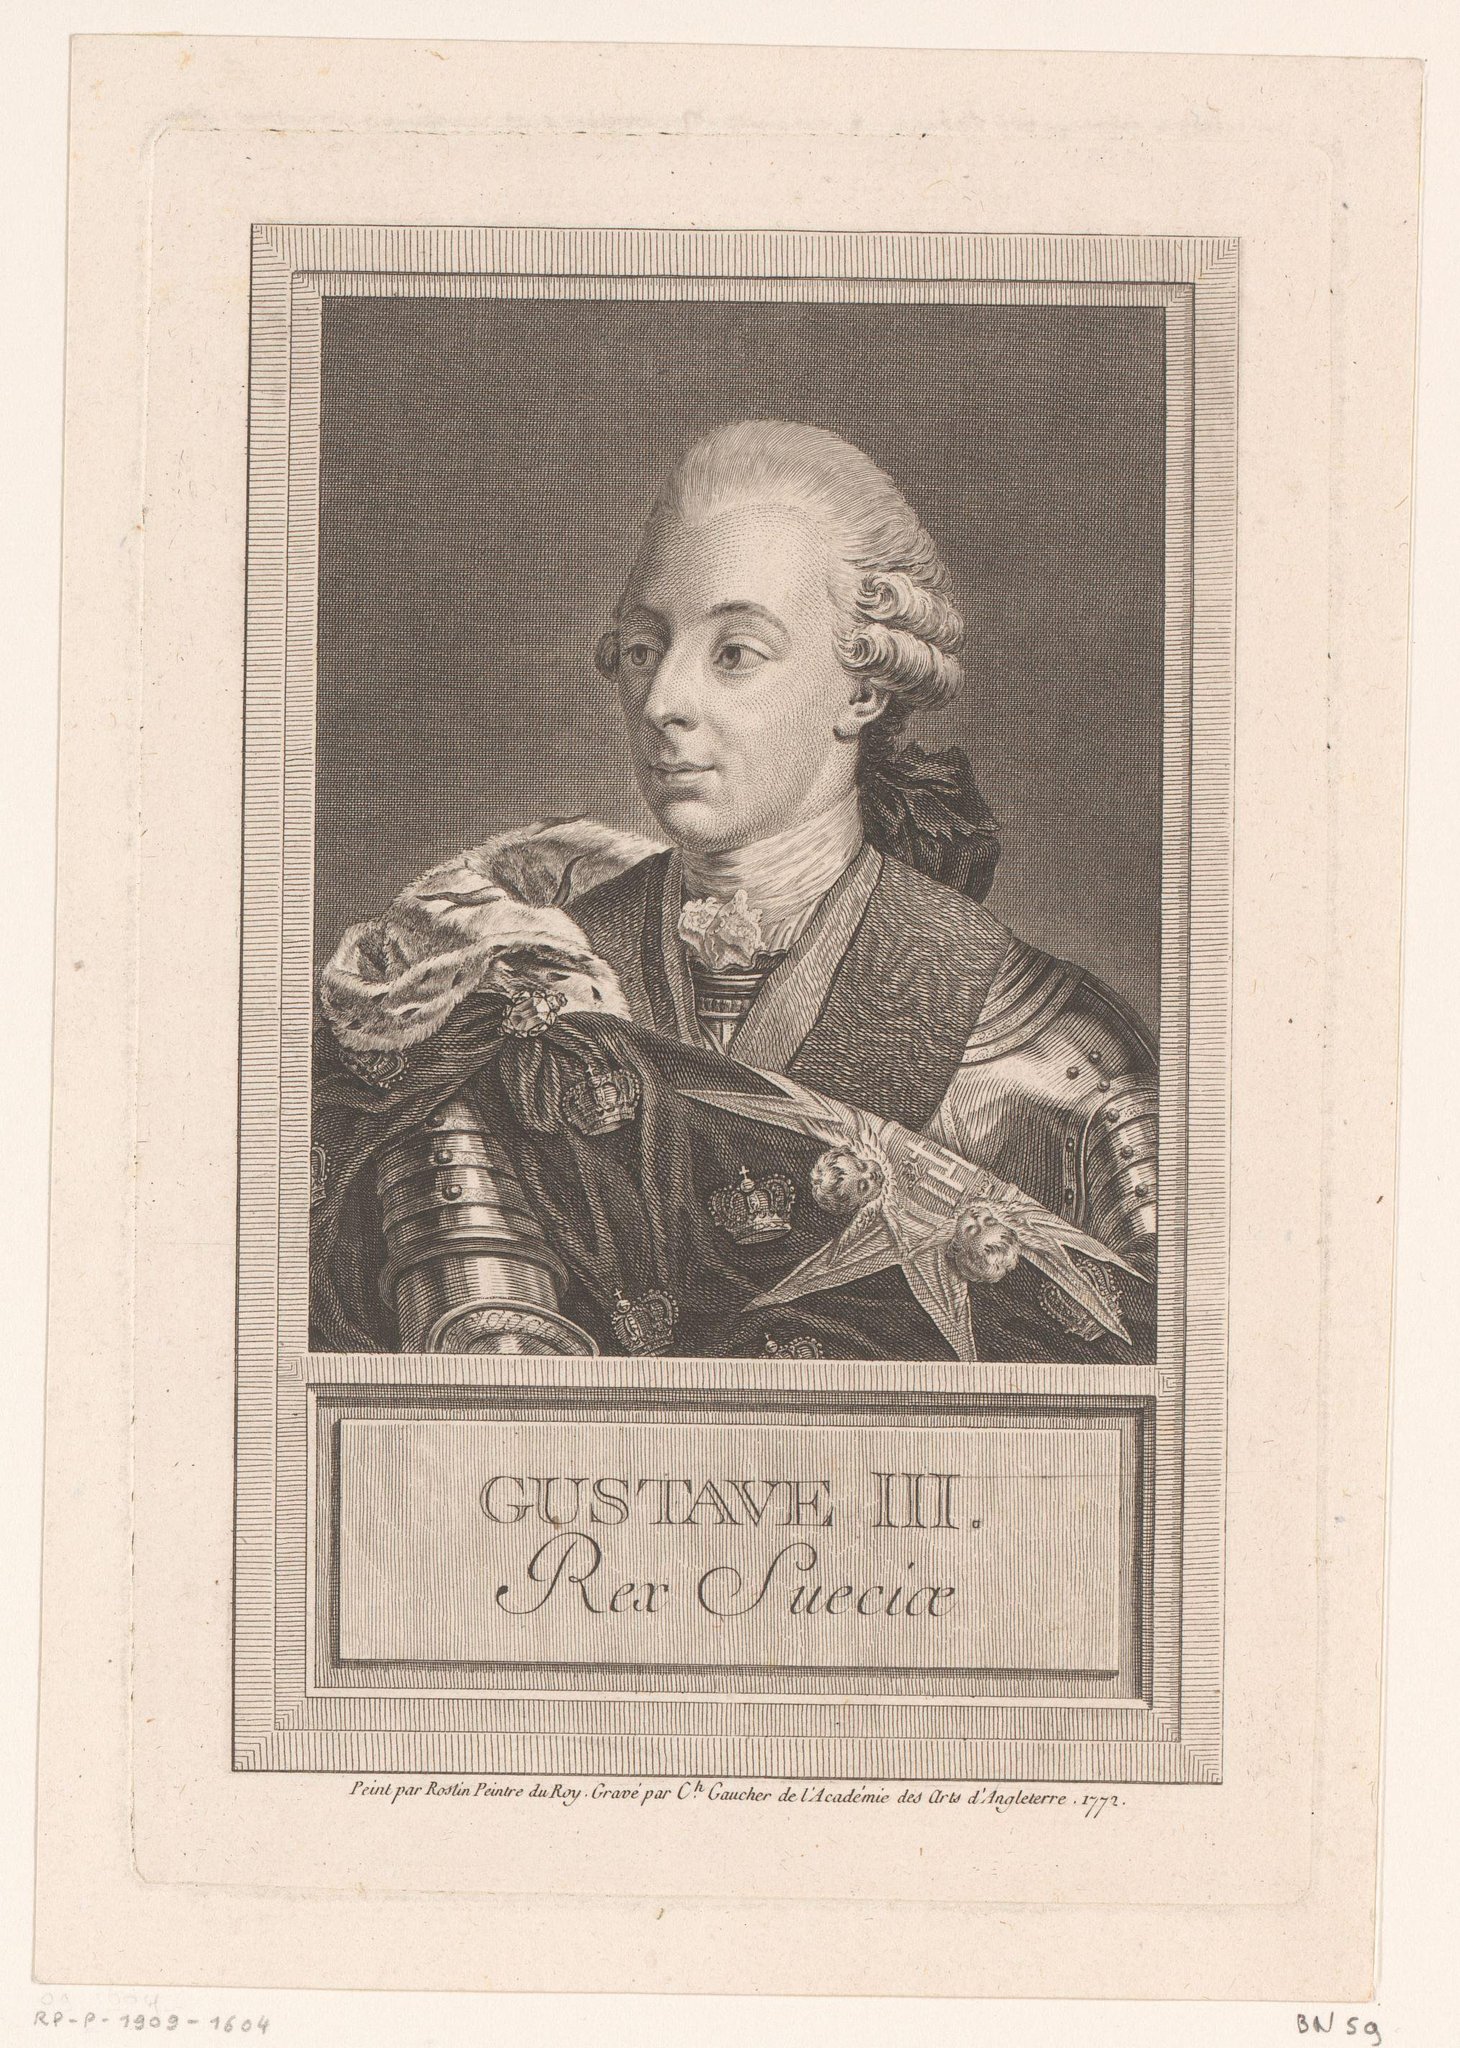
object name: print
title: Gustave III. Rex Sueciae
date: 1772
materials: paper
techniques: engraving, etching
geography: england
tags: armour, historical persons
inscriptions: collector's mark: Lugt 2228